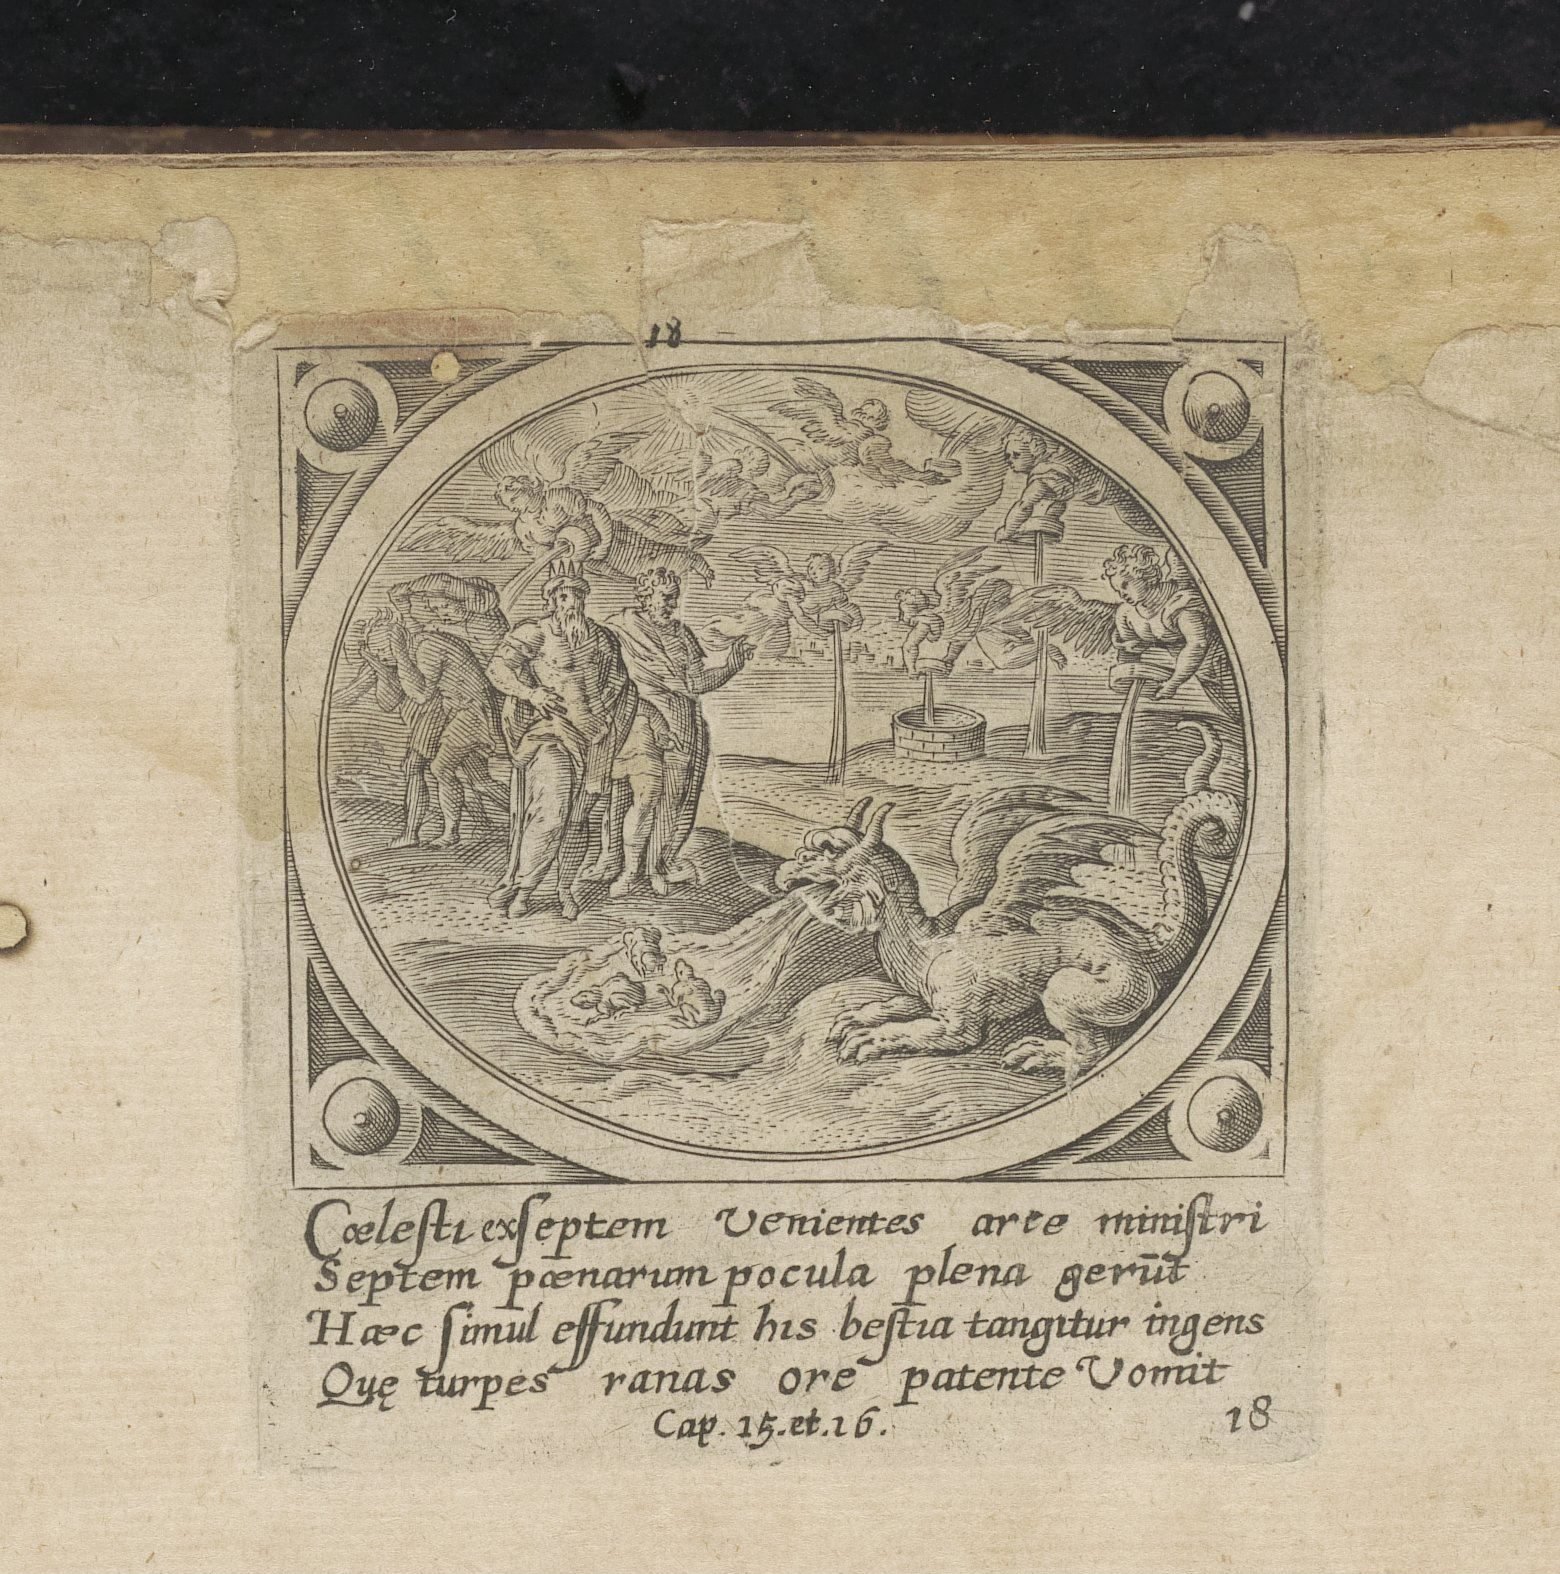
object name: album leaf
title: Van den Apocalipsis oft Openbaeringh Iohannis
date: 1585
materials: paper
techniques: engraving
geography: alkmaar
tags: the seven angels with the seven vials, bringing disasters and destruction upon the earth and mankind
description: Engelen gieten schalen leeg die plagen veroorzaken. Op de voorgrond de zesde plaag: een draak die kikkers braakt. Onder de voorstelling een verwijzing in het Latijn naar de Bijbeltekst in Op. 15-16. Deze prent maakt deel uit van een album.